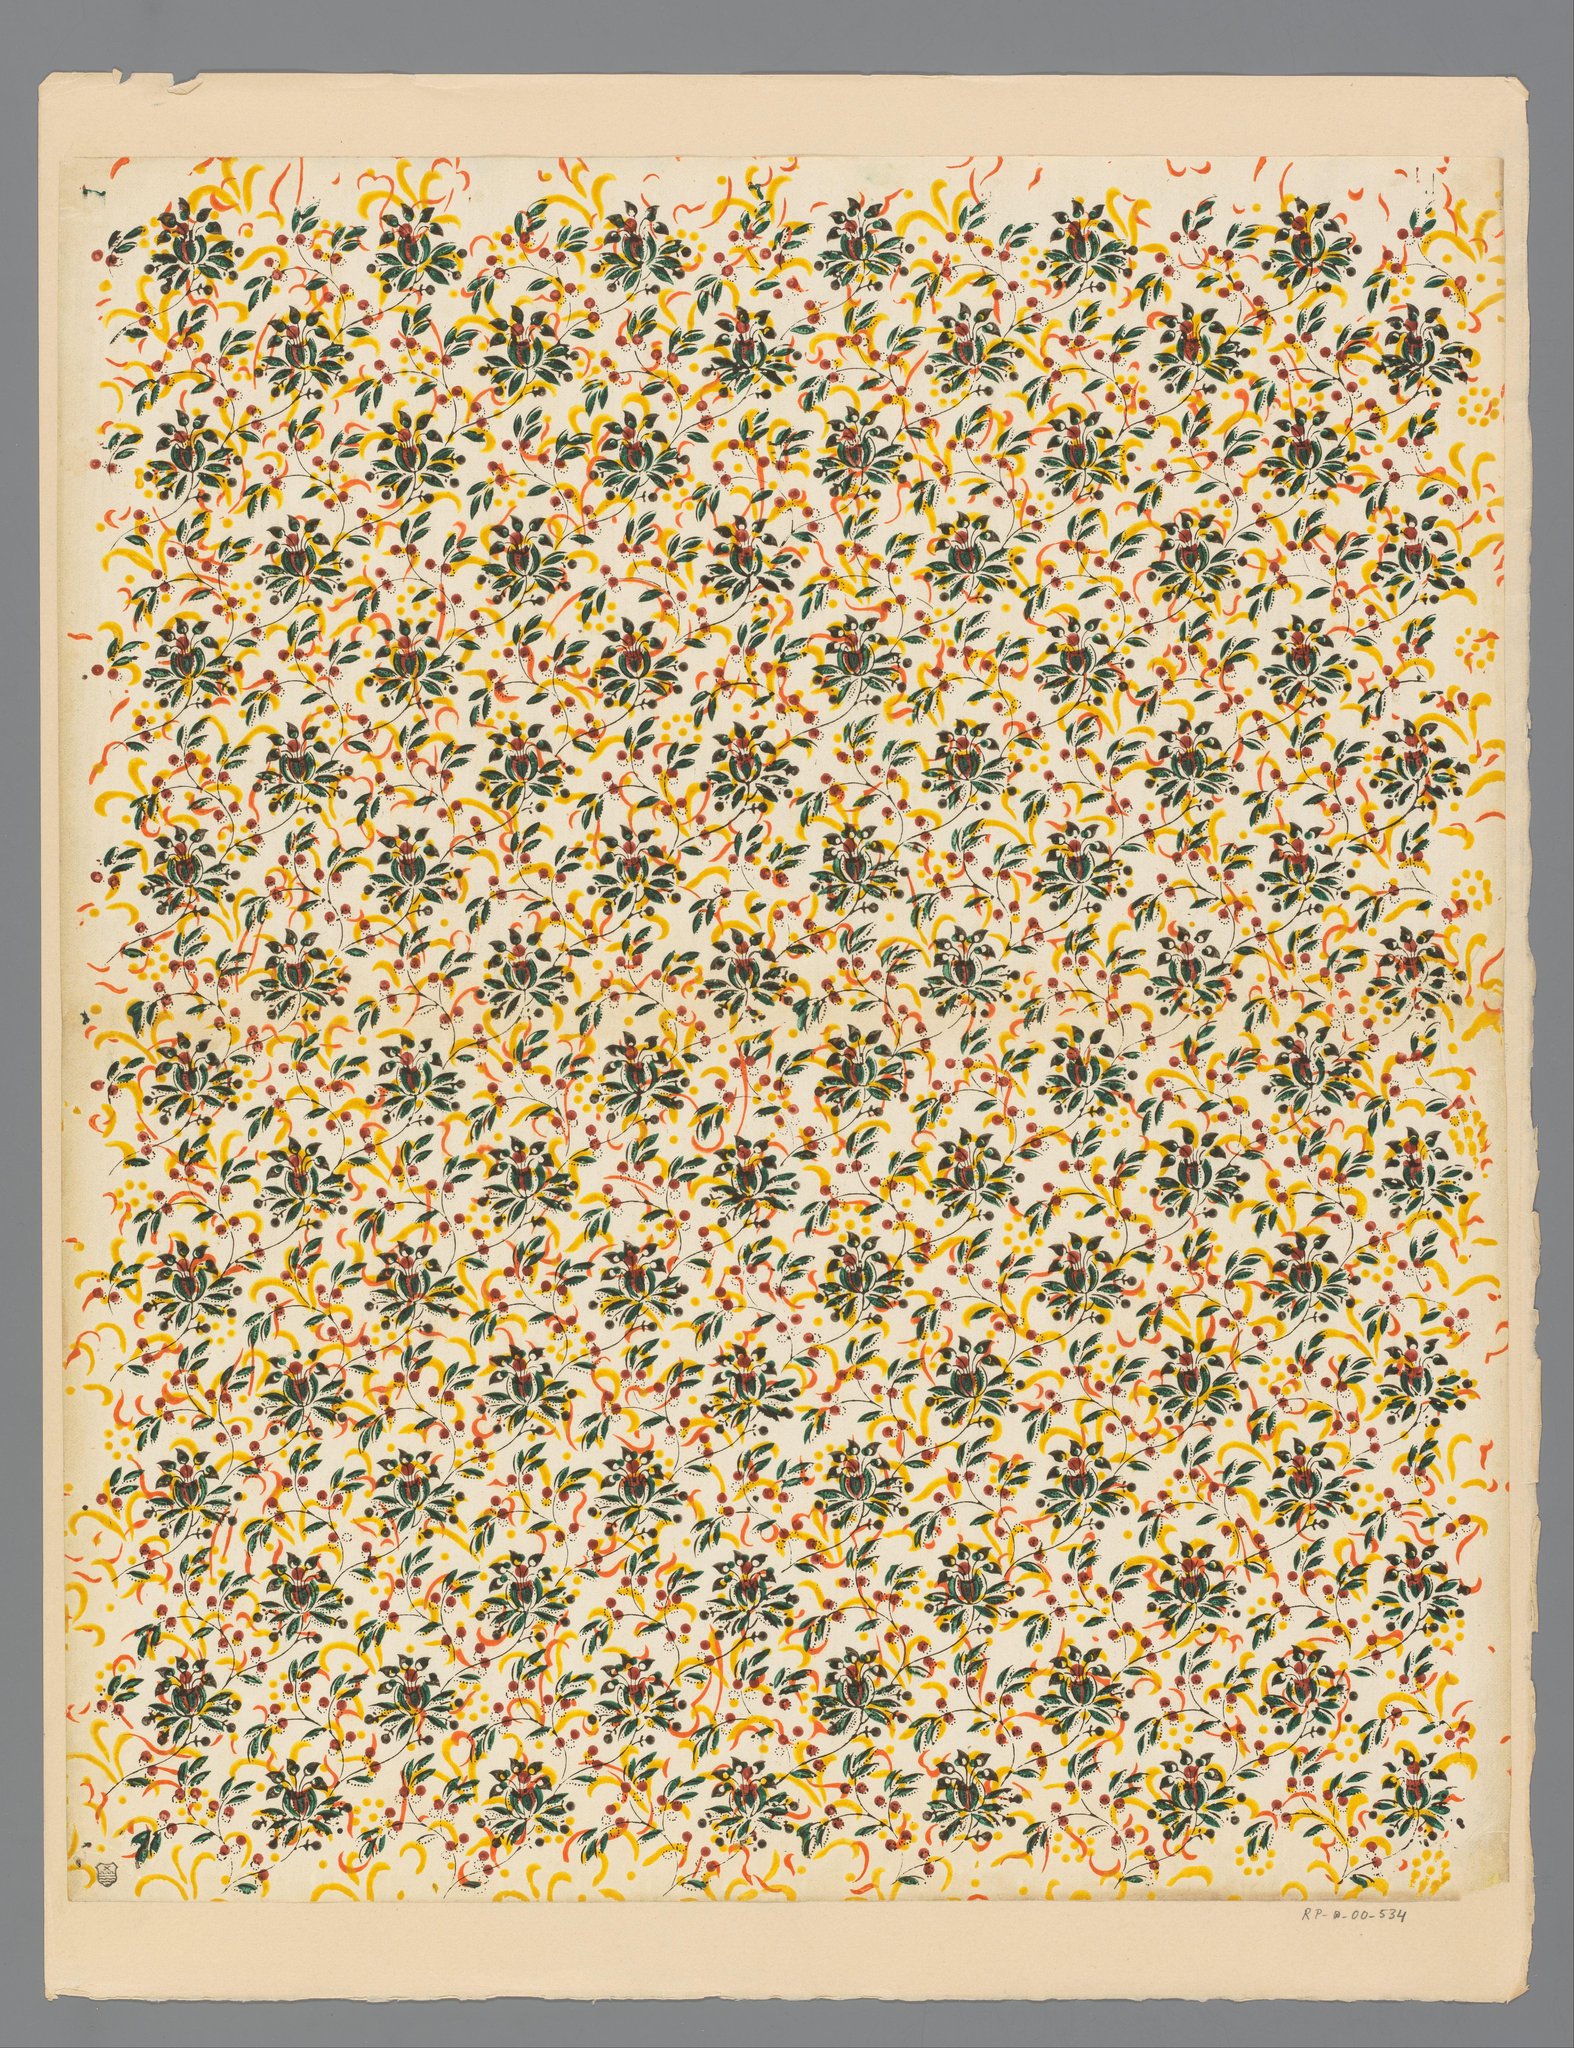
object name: printed paper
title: Blad met strooipatroon van ranken met bloemen, bladeren en vruchten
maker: Anonymous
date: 1800-1900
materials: paper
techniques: printing block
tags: ornament derived from plant forms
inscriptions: collector's mark: Lugt 2760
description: Blad met strooipatroon van ranken met bloemen, bladeren en vruchten over ranken met bessen.